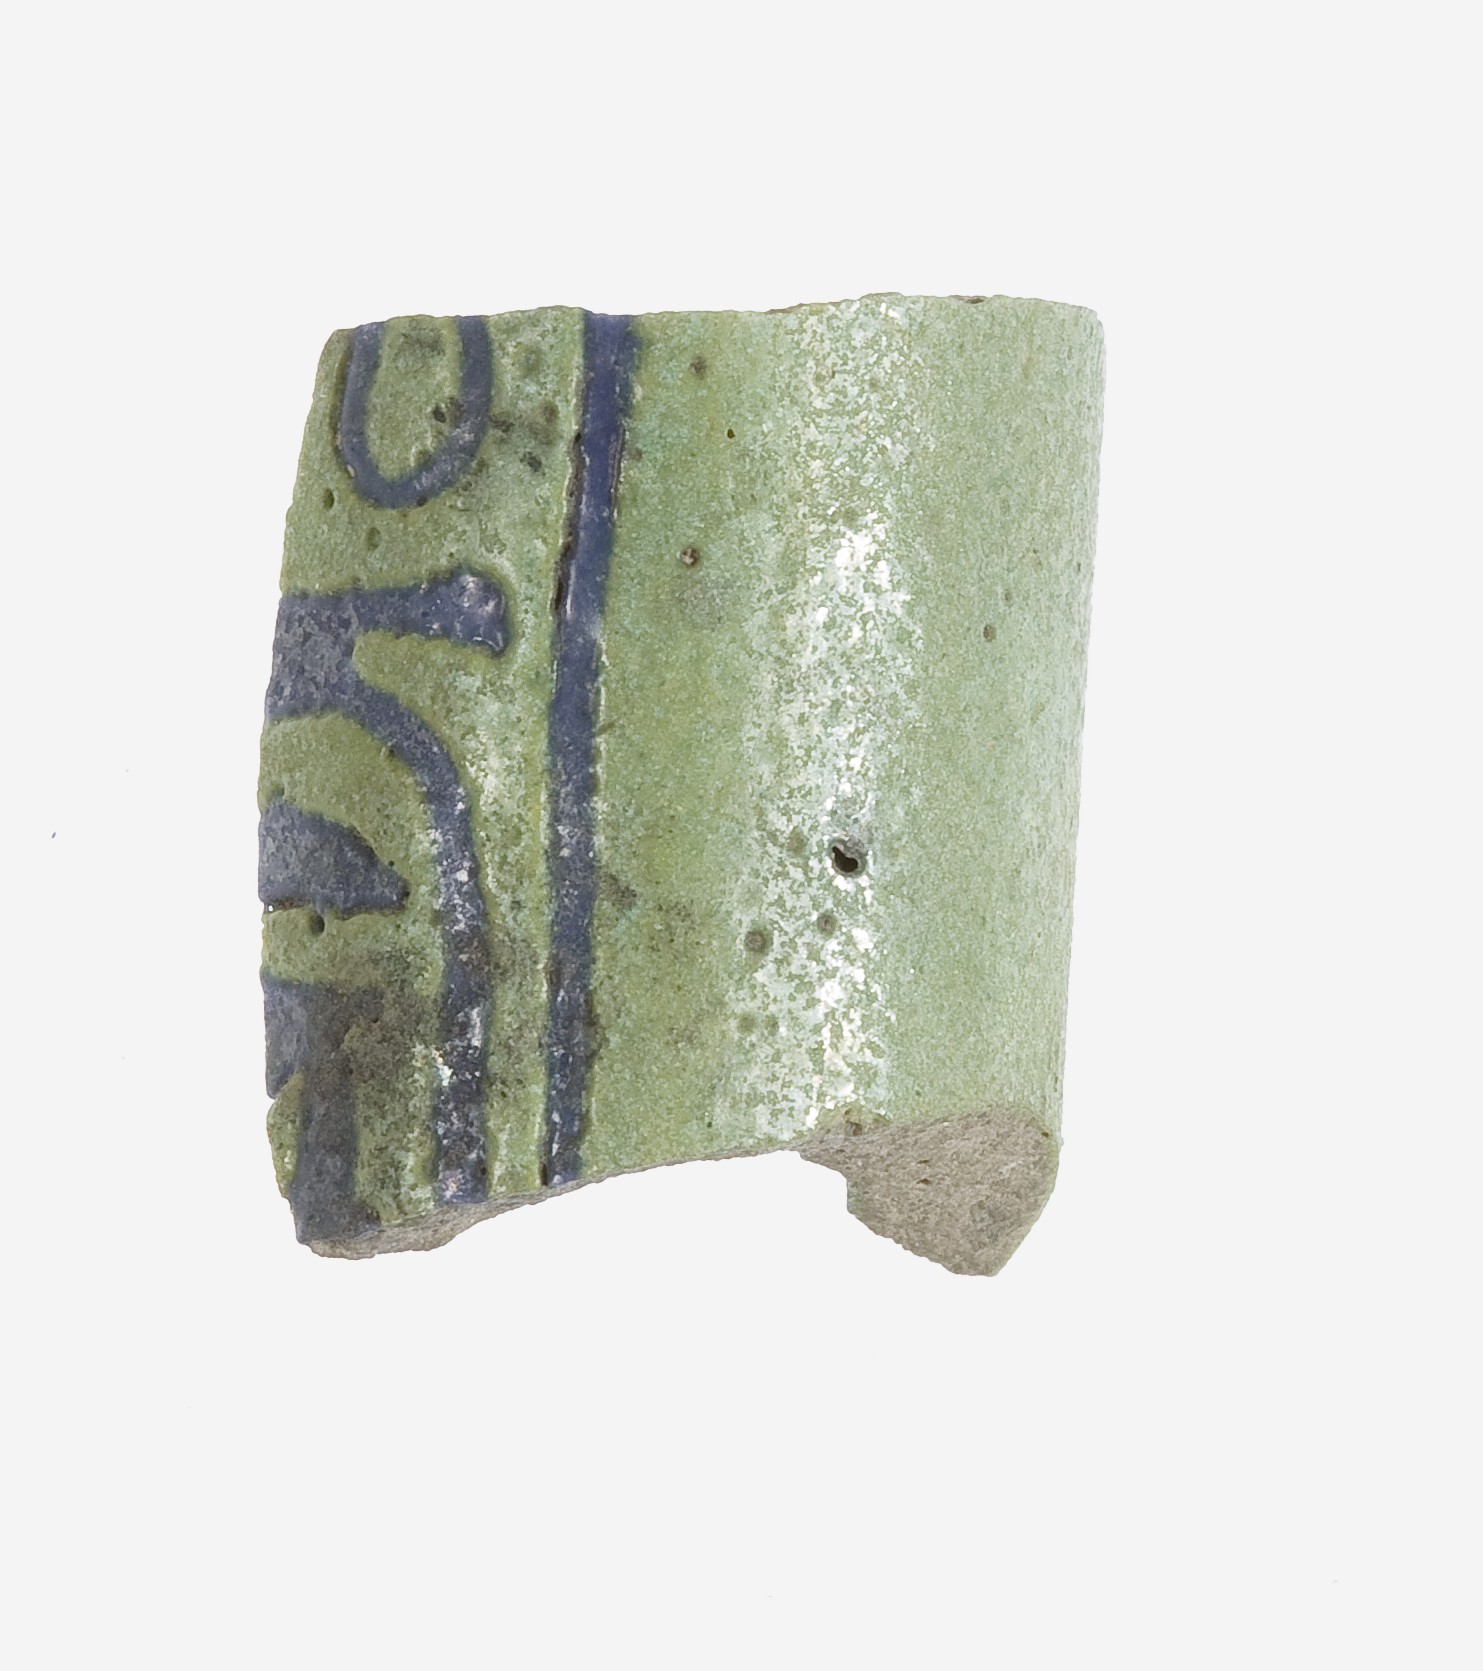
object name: kohl tube fragment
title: Fragment of Kohl Tube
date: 1390-1352 BCE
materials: faience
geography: egypt